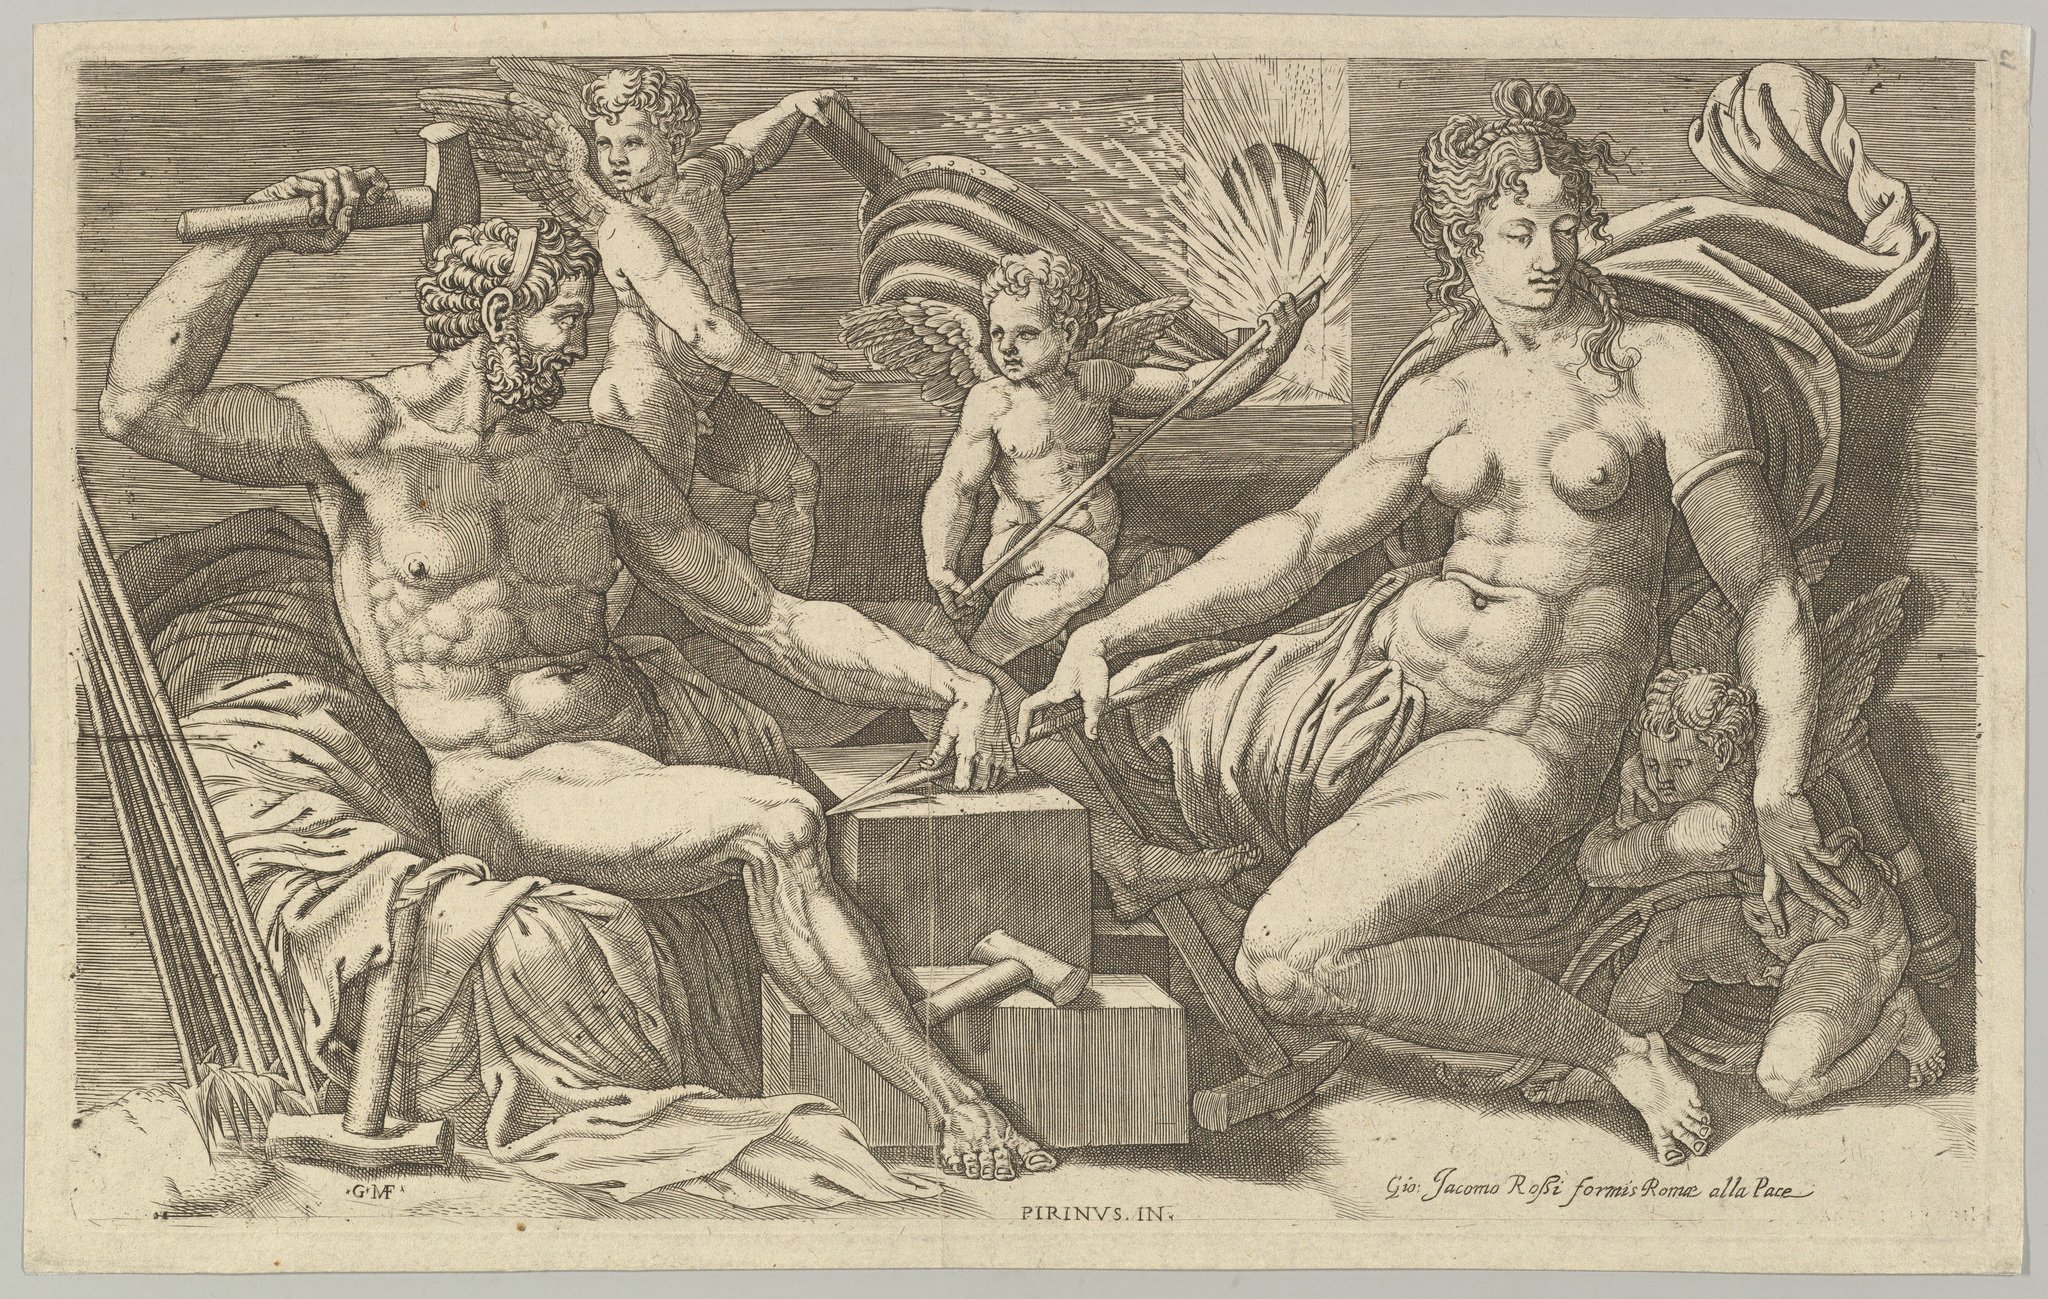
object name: print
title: Venus and Vulcan at the Forge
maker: giorgio ghisi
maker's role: artist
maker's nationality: italian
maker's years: 1515-1582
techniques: engraving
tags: arrows,venus,vulcan,hammers